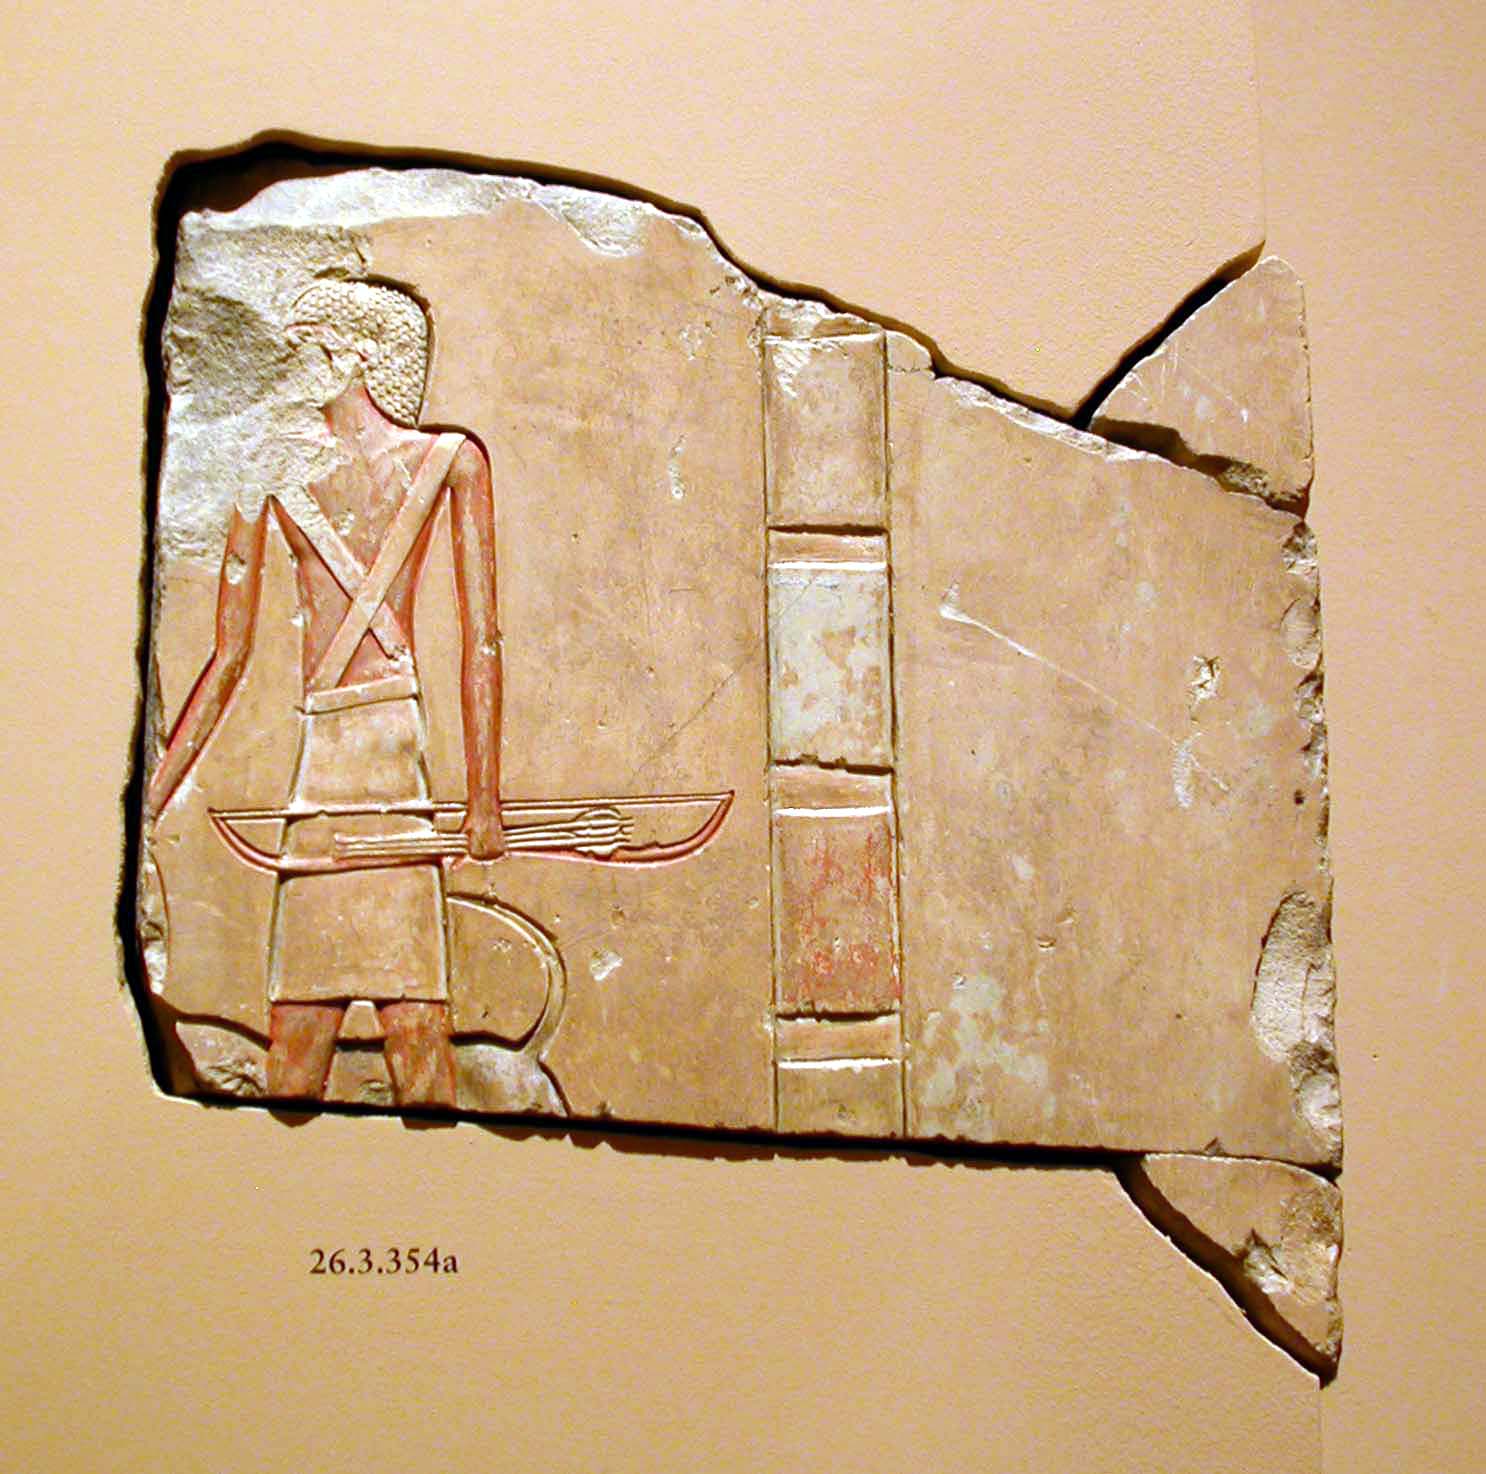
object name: relief, tomb of khety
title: Inscribed block with bowman and dog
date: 2051-2000 BCE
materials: limestone, paint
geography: egypt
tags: bow and arrow,men